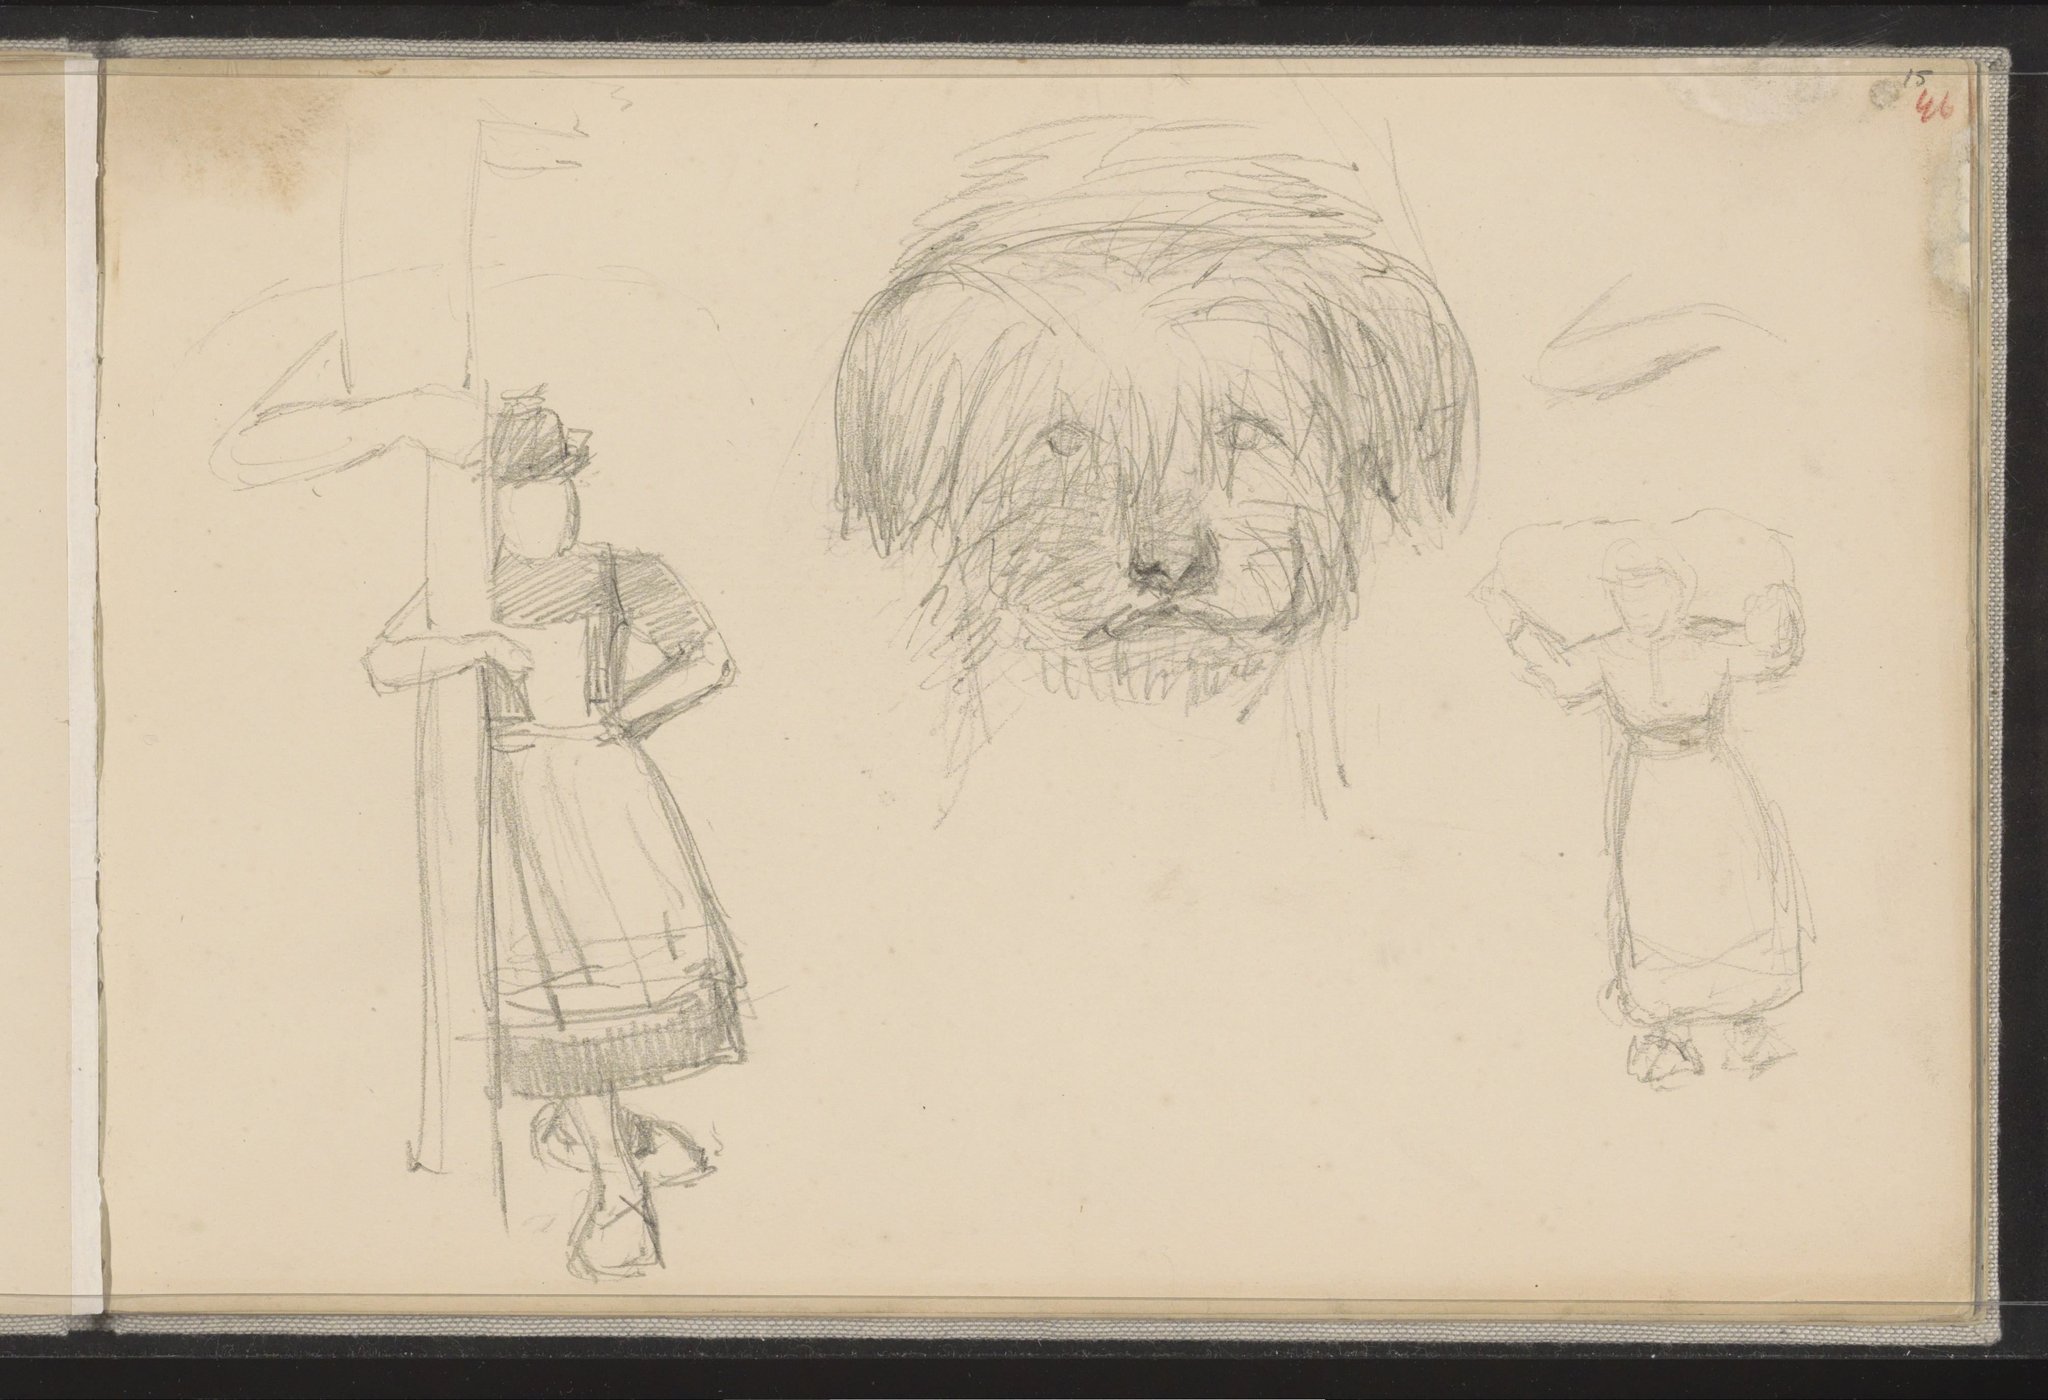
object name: sketchbook leaf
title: Studieblad, onder andere met een hondenkop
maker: jozef israëls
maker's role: draughtsman, painter, print maker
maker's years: 1824-1911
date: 1834-1911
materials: paper, pencil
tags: leaning figure - aa - female human figure, jumping-rope games, dog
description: Tevens studies van een boerenmeisje dat tegen een paal leunt en een vrouw die touwtje springt. Blad 15 recto uit een schetsboek met 30 bladen.